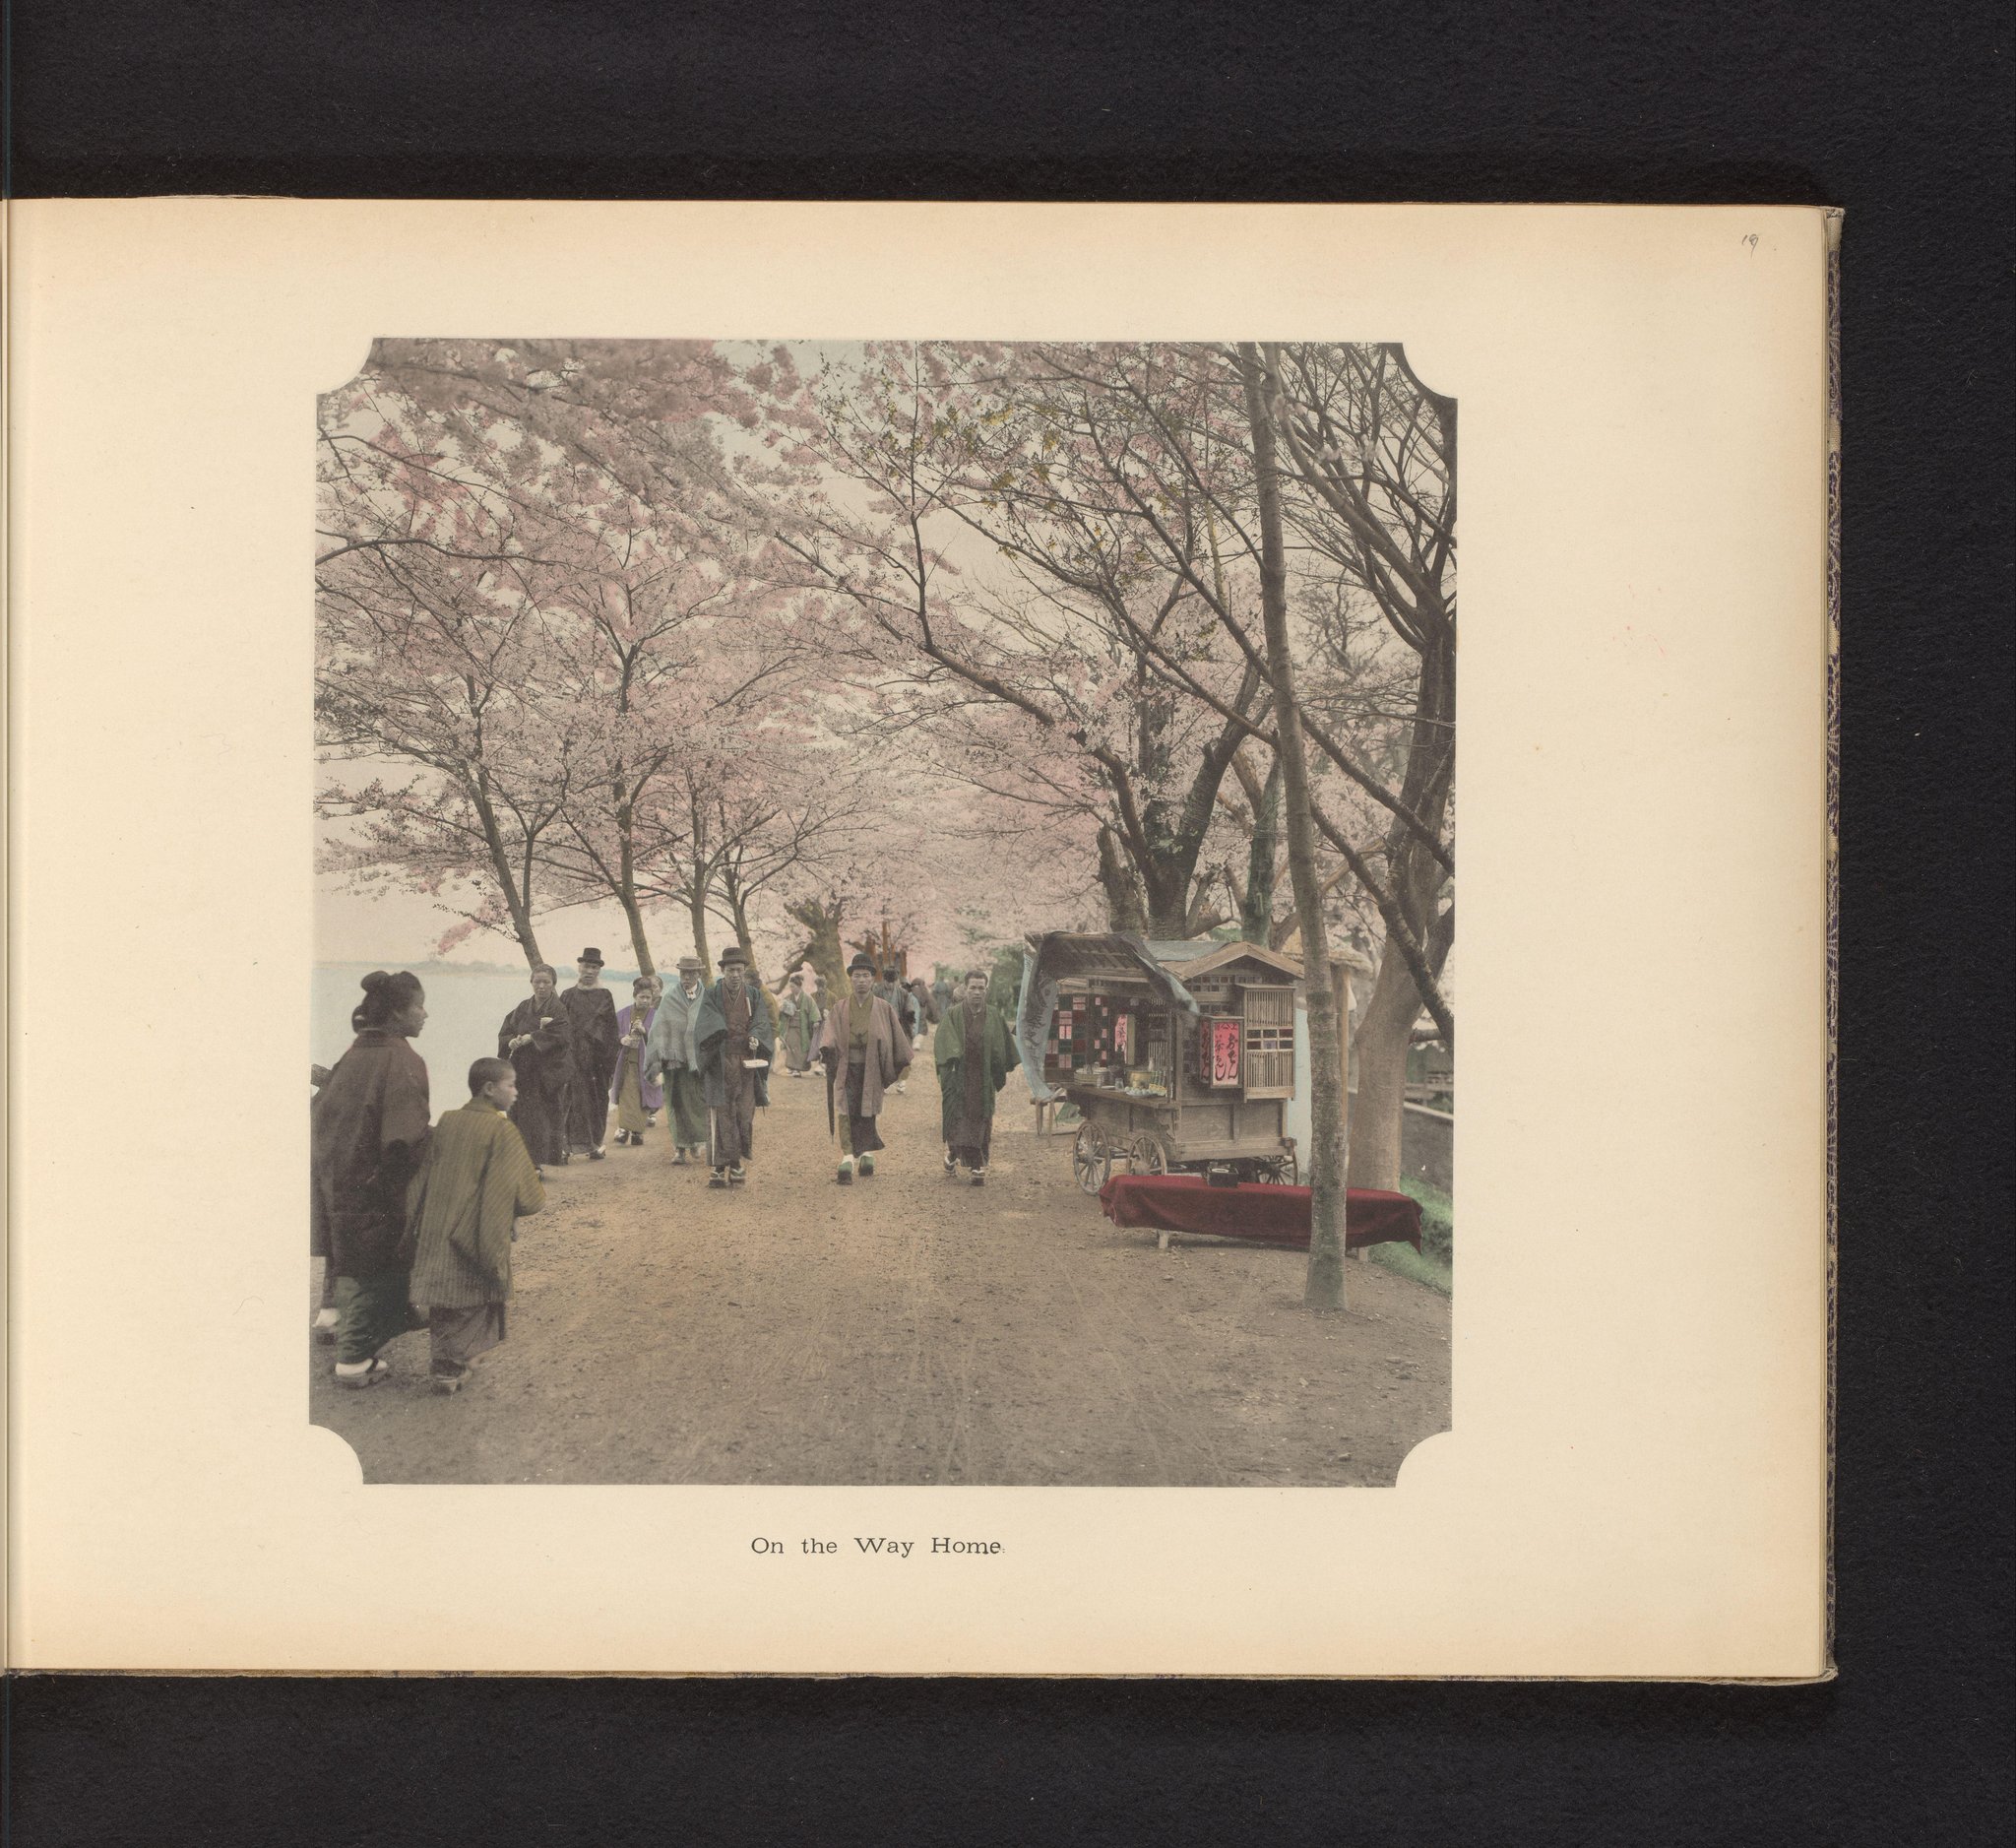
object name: page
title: On the Way Home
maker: kazumasa ogawa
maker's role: auteur, fotograaf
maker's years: 1860-1929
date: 1892-1897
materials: paper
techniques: photograph, hand coloring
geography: uenopark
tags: park, road, path, river bank (+ landscape with figures, staffage)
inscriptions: number: ‘19’